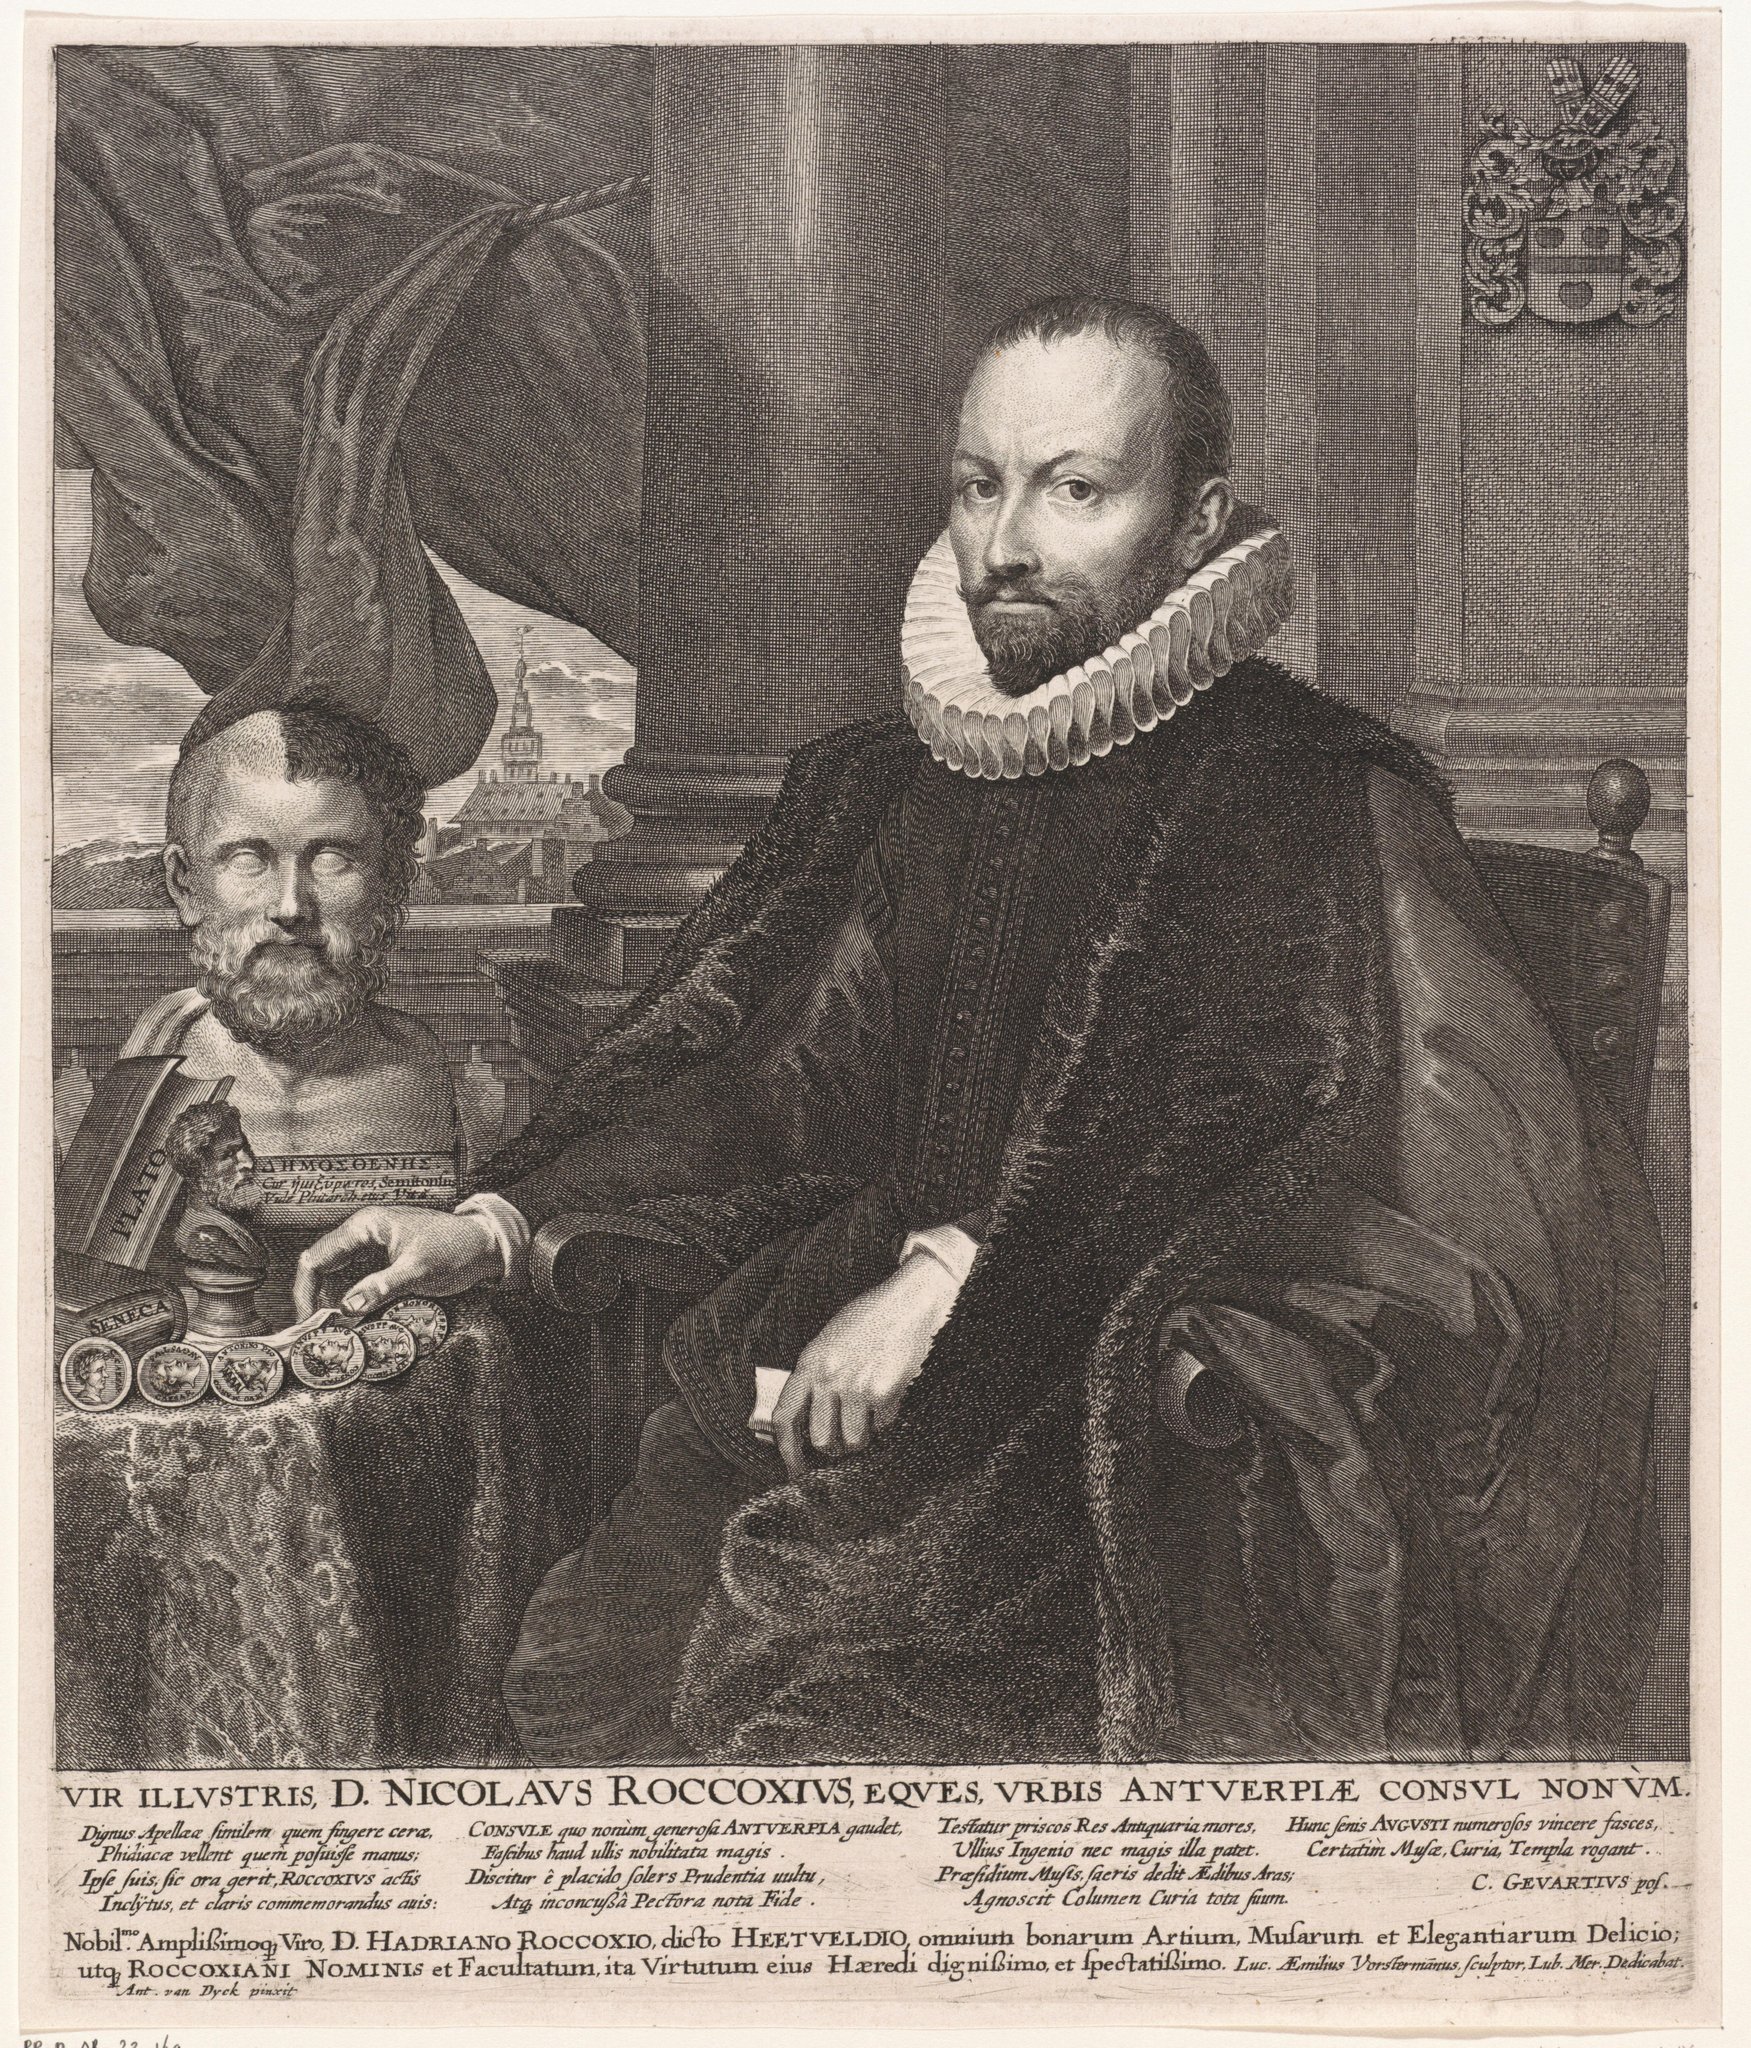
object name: print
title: Portret van Nikolaas Rockox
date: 1625-1666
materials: paper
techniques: engraving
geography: antwerp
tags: antwerp, mayor, nikolaas rockox, (story of) demosthenes - portrait of person from classical history (+ full face)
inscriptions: collector's mark: Lugt 240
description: Portret van Nikolaas Rockox, burgemeester van Antwerpen en kunstliefhebber. Hij zit in een interieur met voor hem op tafel boeken en kunstvoorwerpen, waaronder een buste van de Griekse redenaar en politicus Demosthenes.